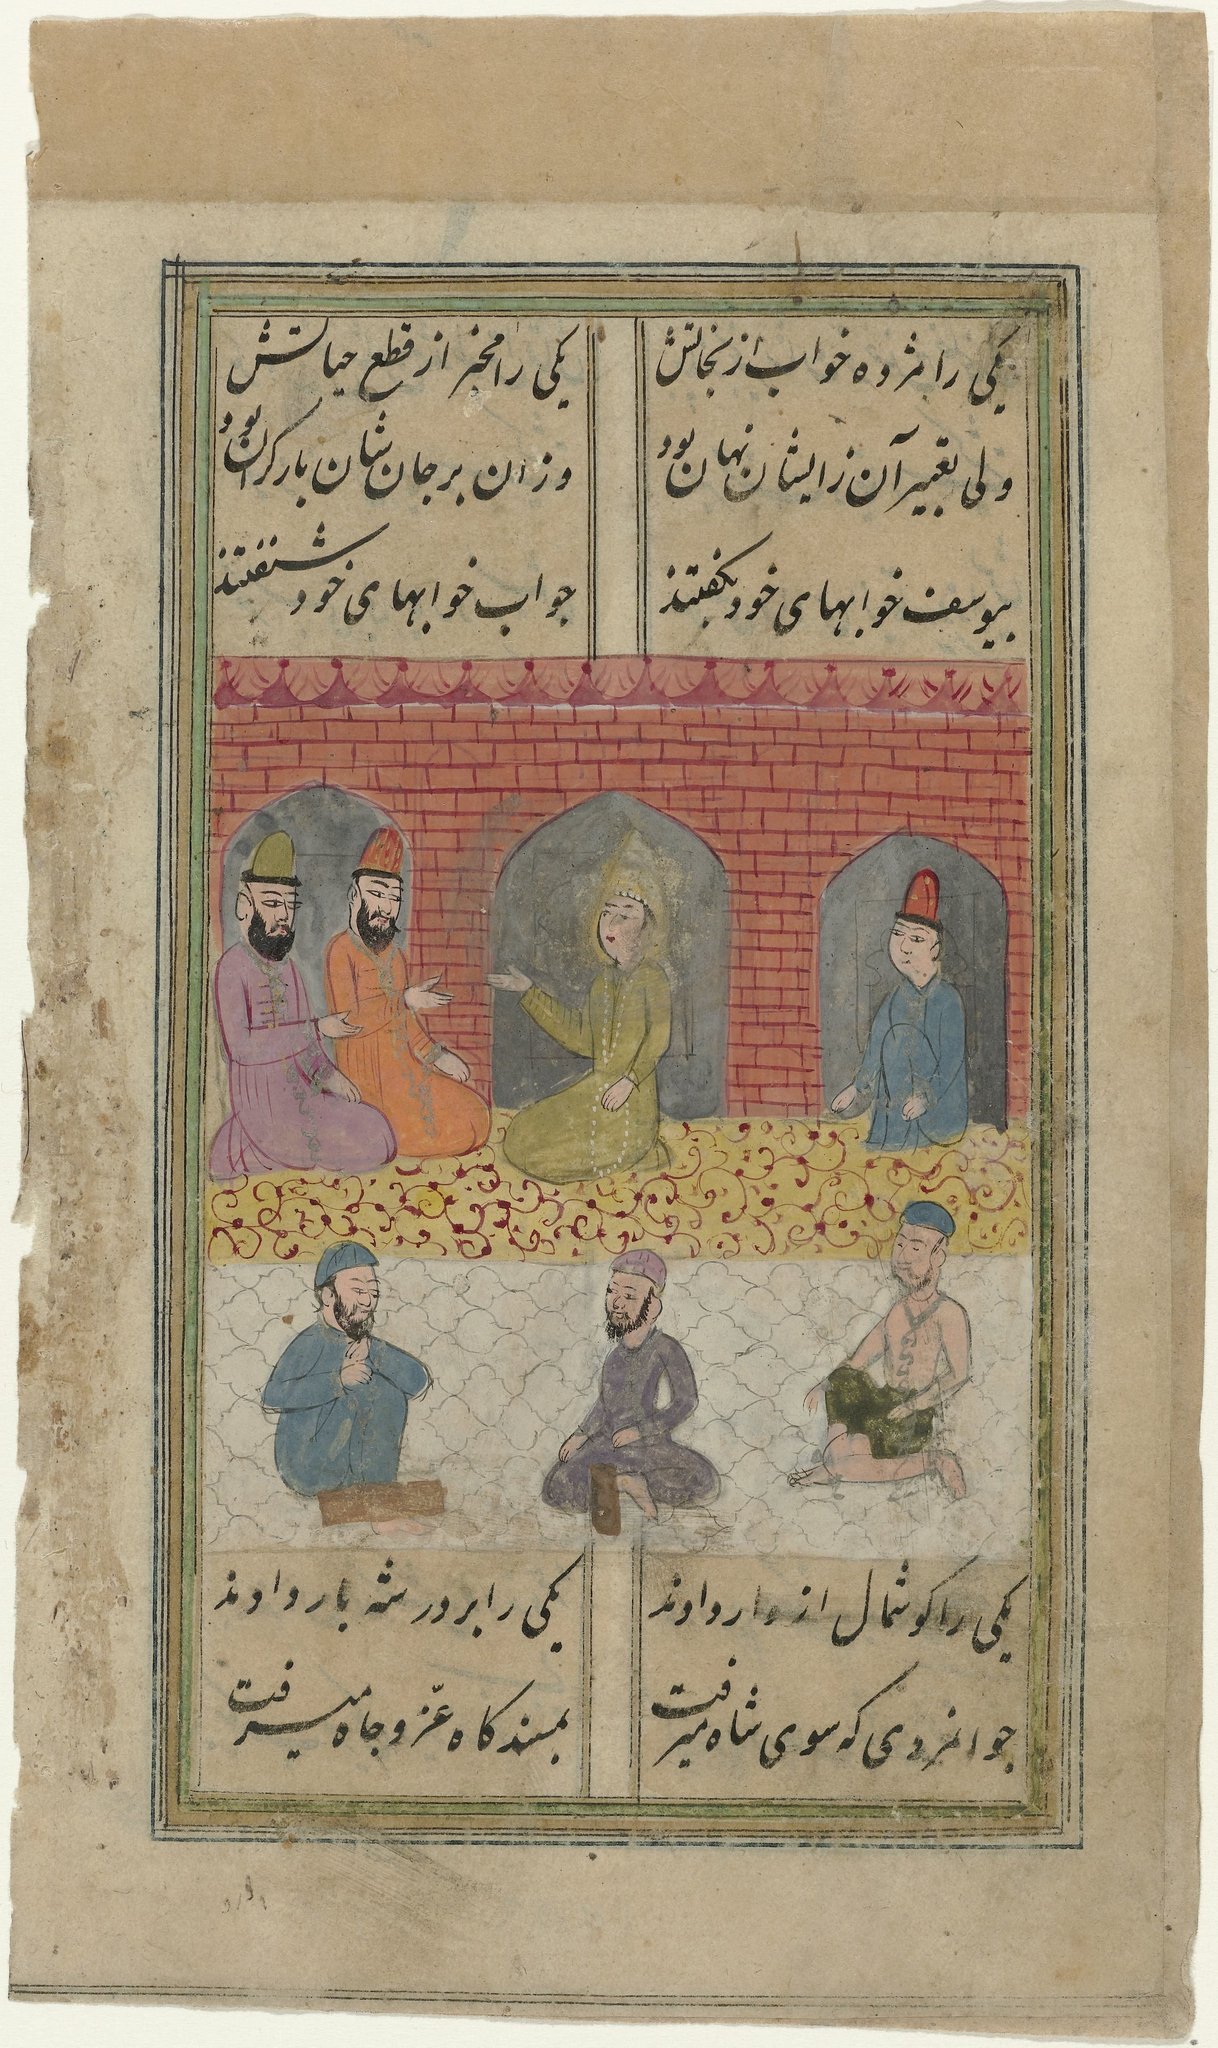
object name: drawing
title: Aantal figuren op een terras voor een rood bakstenen gebouw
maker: Anonymous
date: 1790-1810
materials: paper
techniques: brush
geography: kashmir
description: Op een terras voor een rood bakstenen muur met drie poorten zitten op de achtergrond voor de poorten vier figuren, op een wit betegeld stuk vooraan zitten drie mannen, in schamele kledij en een half ontbloot; de voorstelling is halverwege het blad geplaatst in twee kolommen tekst in Perzisch handschrift. De voorstelling ligt in het midden van het blad en bedekt de breedte van twee kolommen tekst die boven en onder de voorstelling zijn gelegen en ook op de achterkant van het blad.